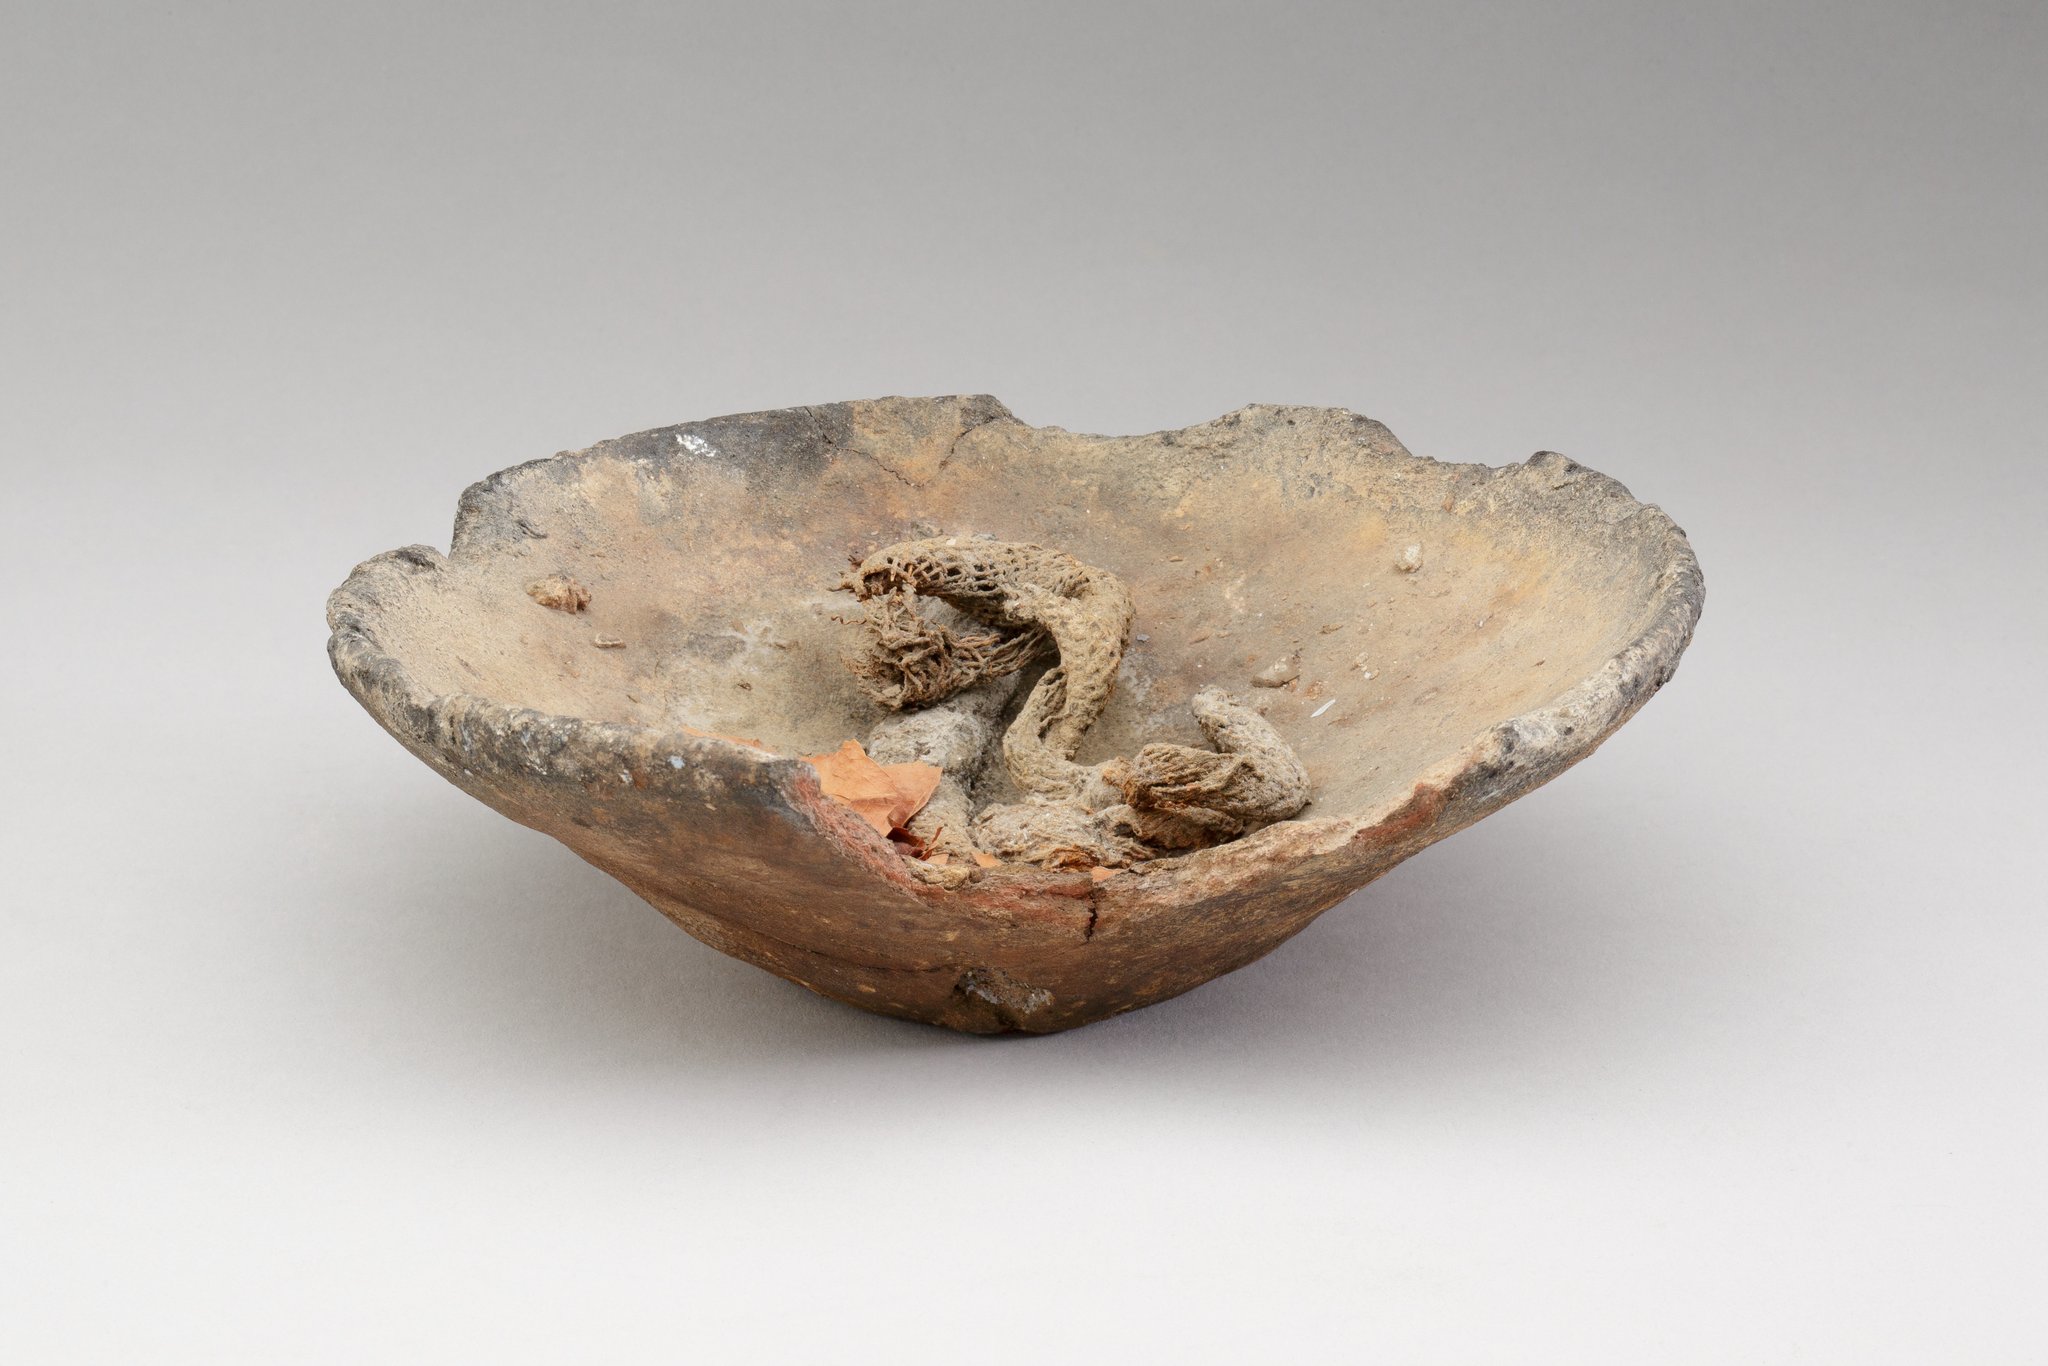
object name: lamp, wick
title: Lamp with a Rag Wick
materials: textile, pottery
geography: egypt